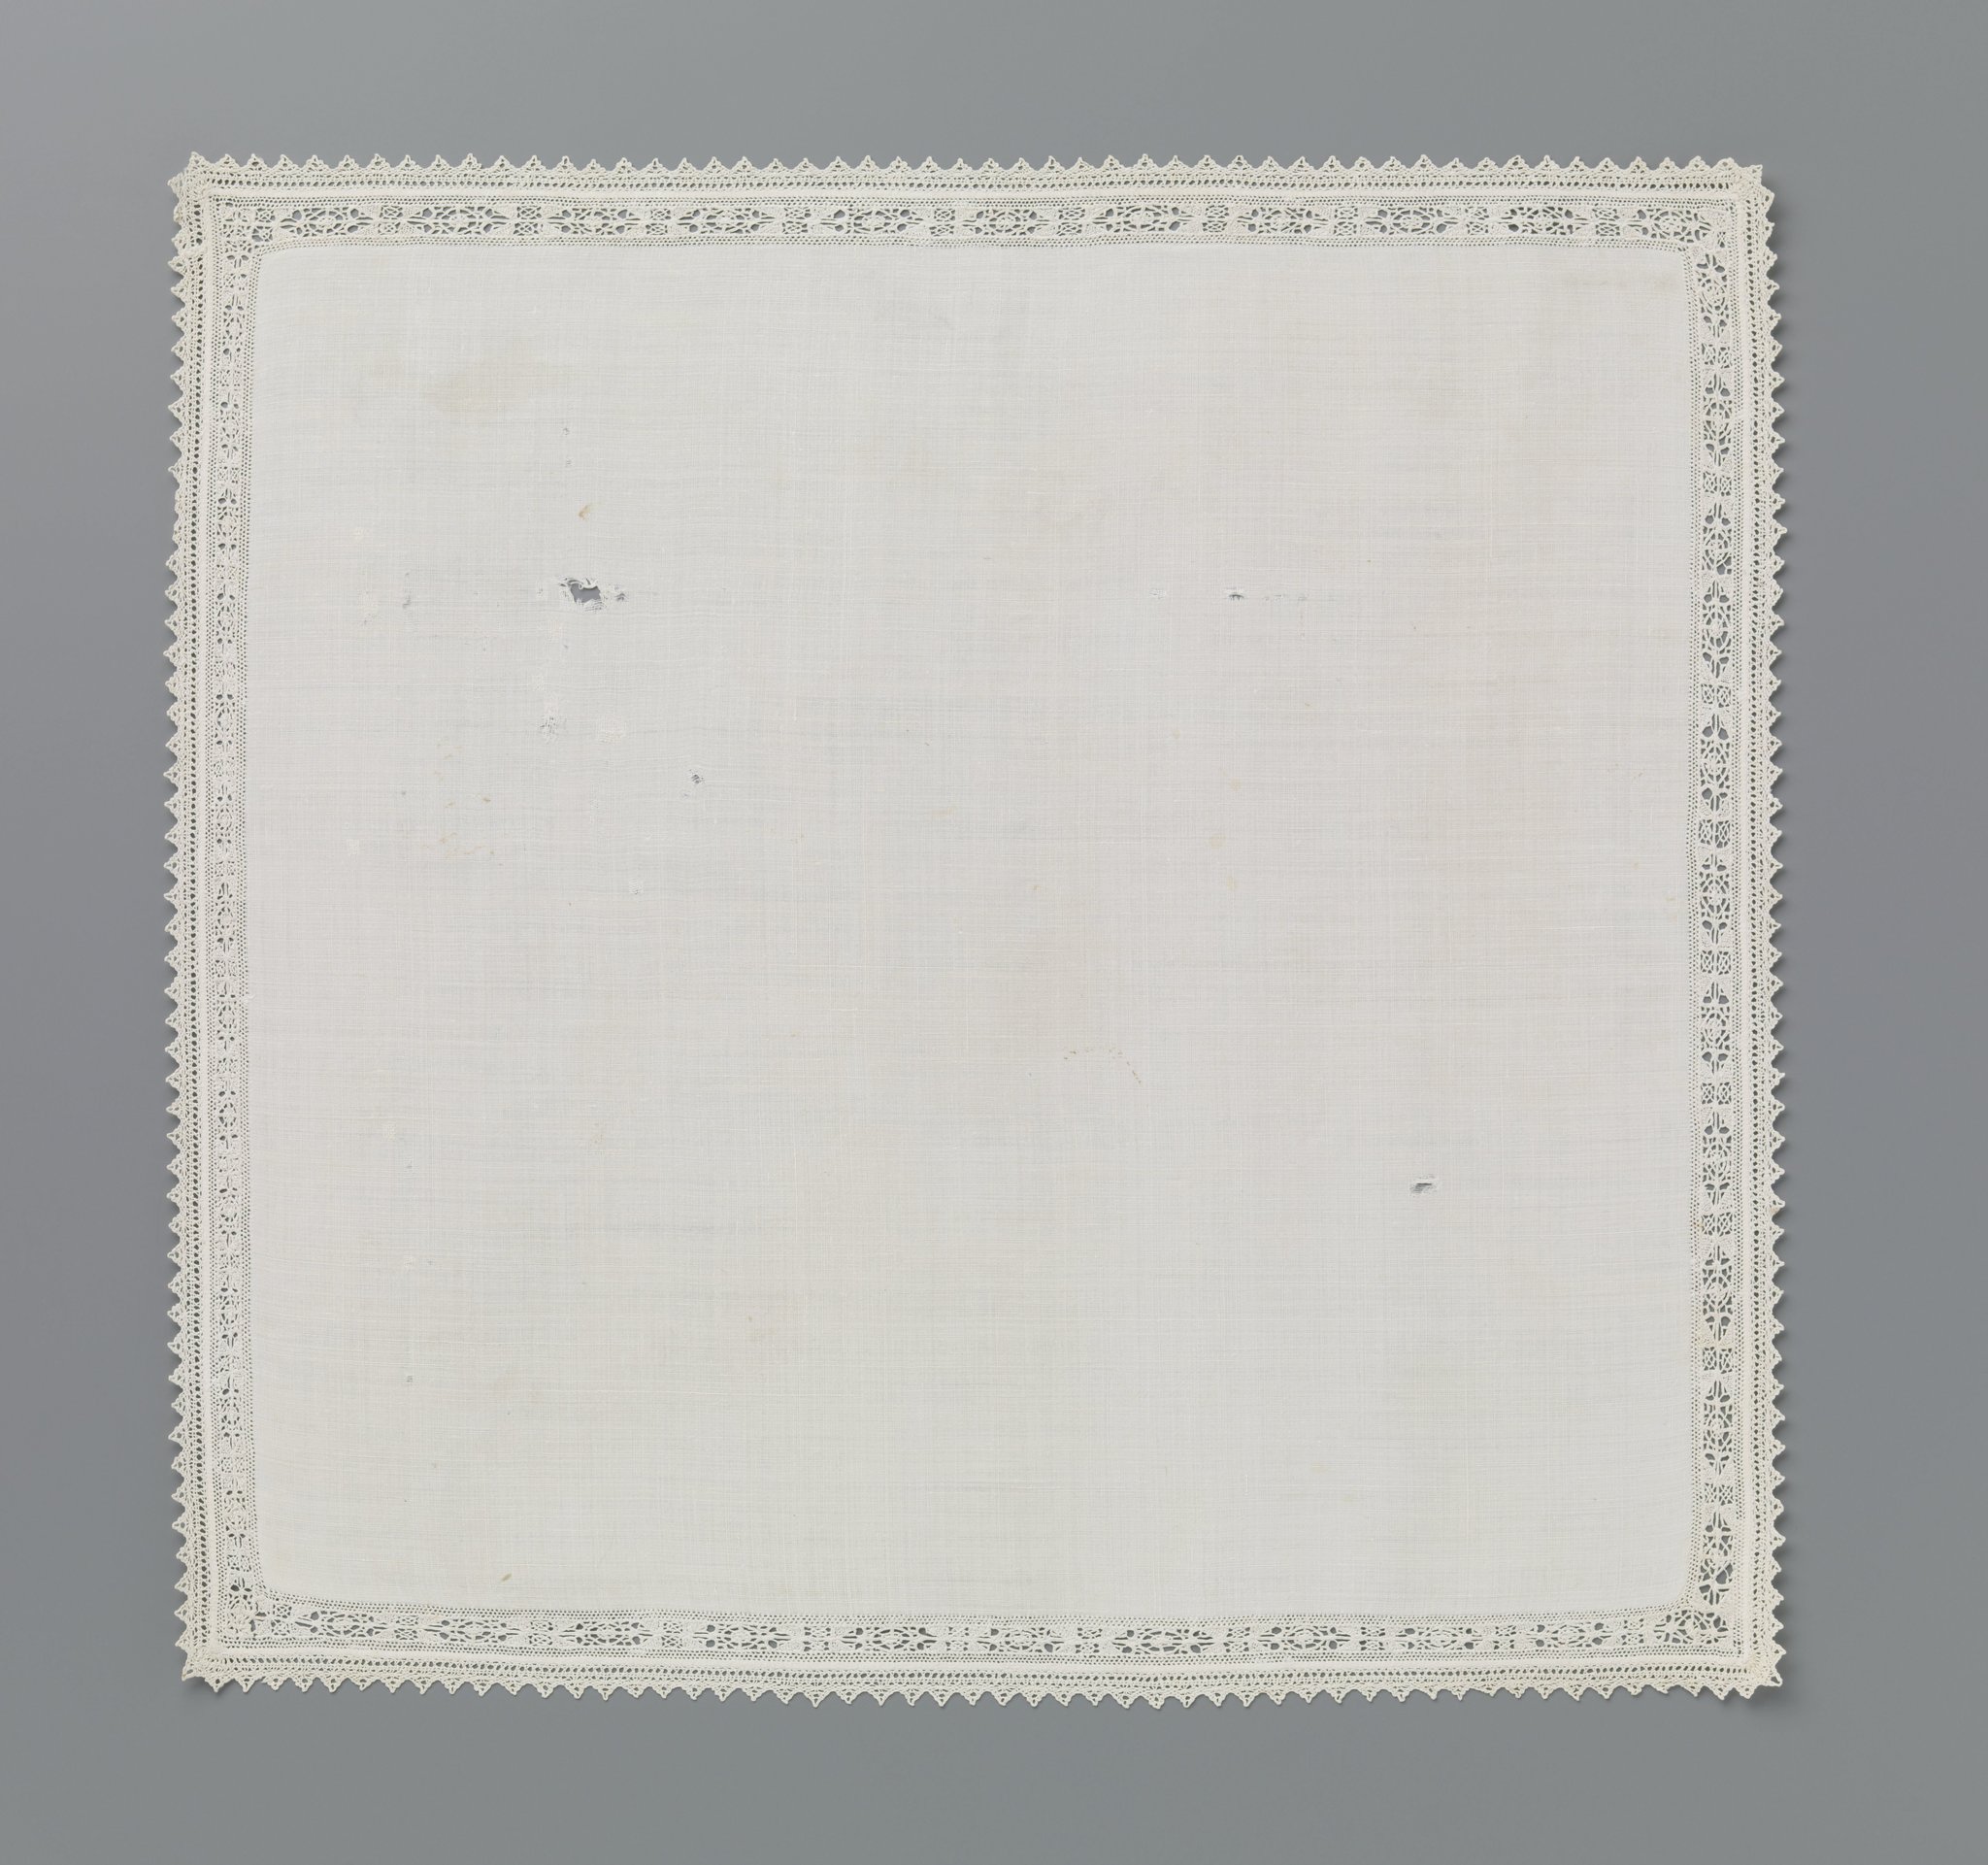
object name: handkerchief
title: Zakdoek van linnen met rondom een baan kantborduurwerk met wielen in opengewerkte rechthoeken en afgewerkt met een rand kloskant met puntschulpjes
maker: Anonymous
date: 1580-1620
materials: linen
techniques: lace, embroidery, weave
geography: italy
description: Zakdoek van naturelkleurig linnen met opengewerkte randen kantborduurwerk: gesneden werk of reticella tussen twee smalle banen werk met samengetrokken draden. Rondom is de zakdoek afgewerkt met naturelkleurige kloskant. Het gesneden werk heeft een zich herhalend en symmetrisch patroon van een rechthoekje met daarin een open zeshoek met wiel. De opeenvolgende rechthoeken worden afgewisseld door twee op elkaar geplaatste kleine opengewerkte vierkantjes, met in elk een wieltje. Het kloskant heeft een zich herhalend patroon van puntschulpjes met in elk schulpje een sterretje en daarboven een rand met kleine en grotere gaatjes.